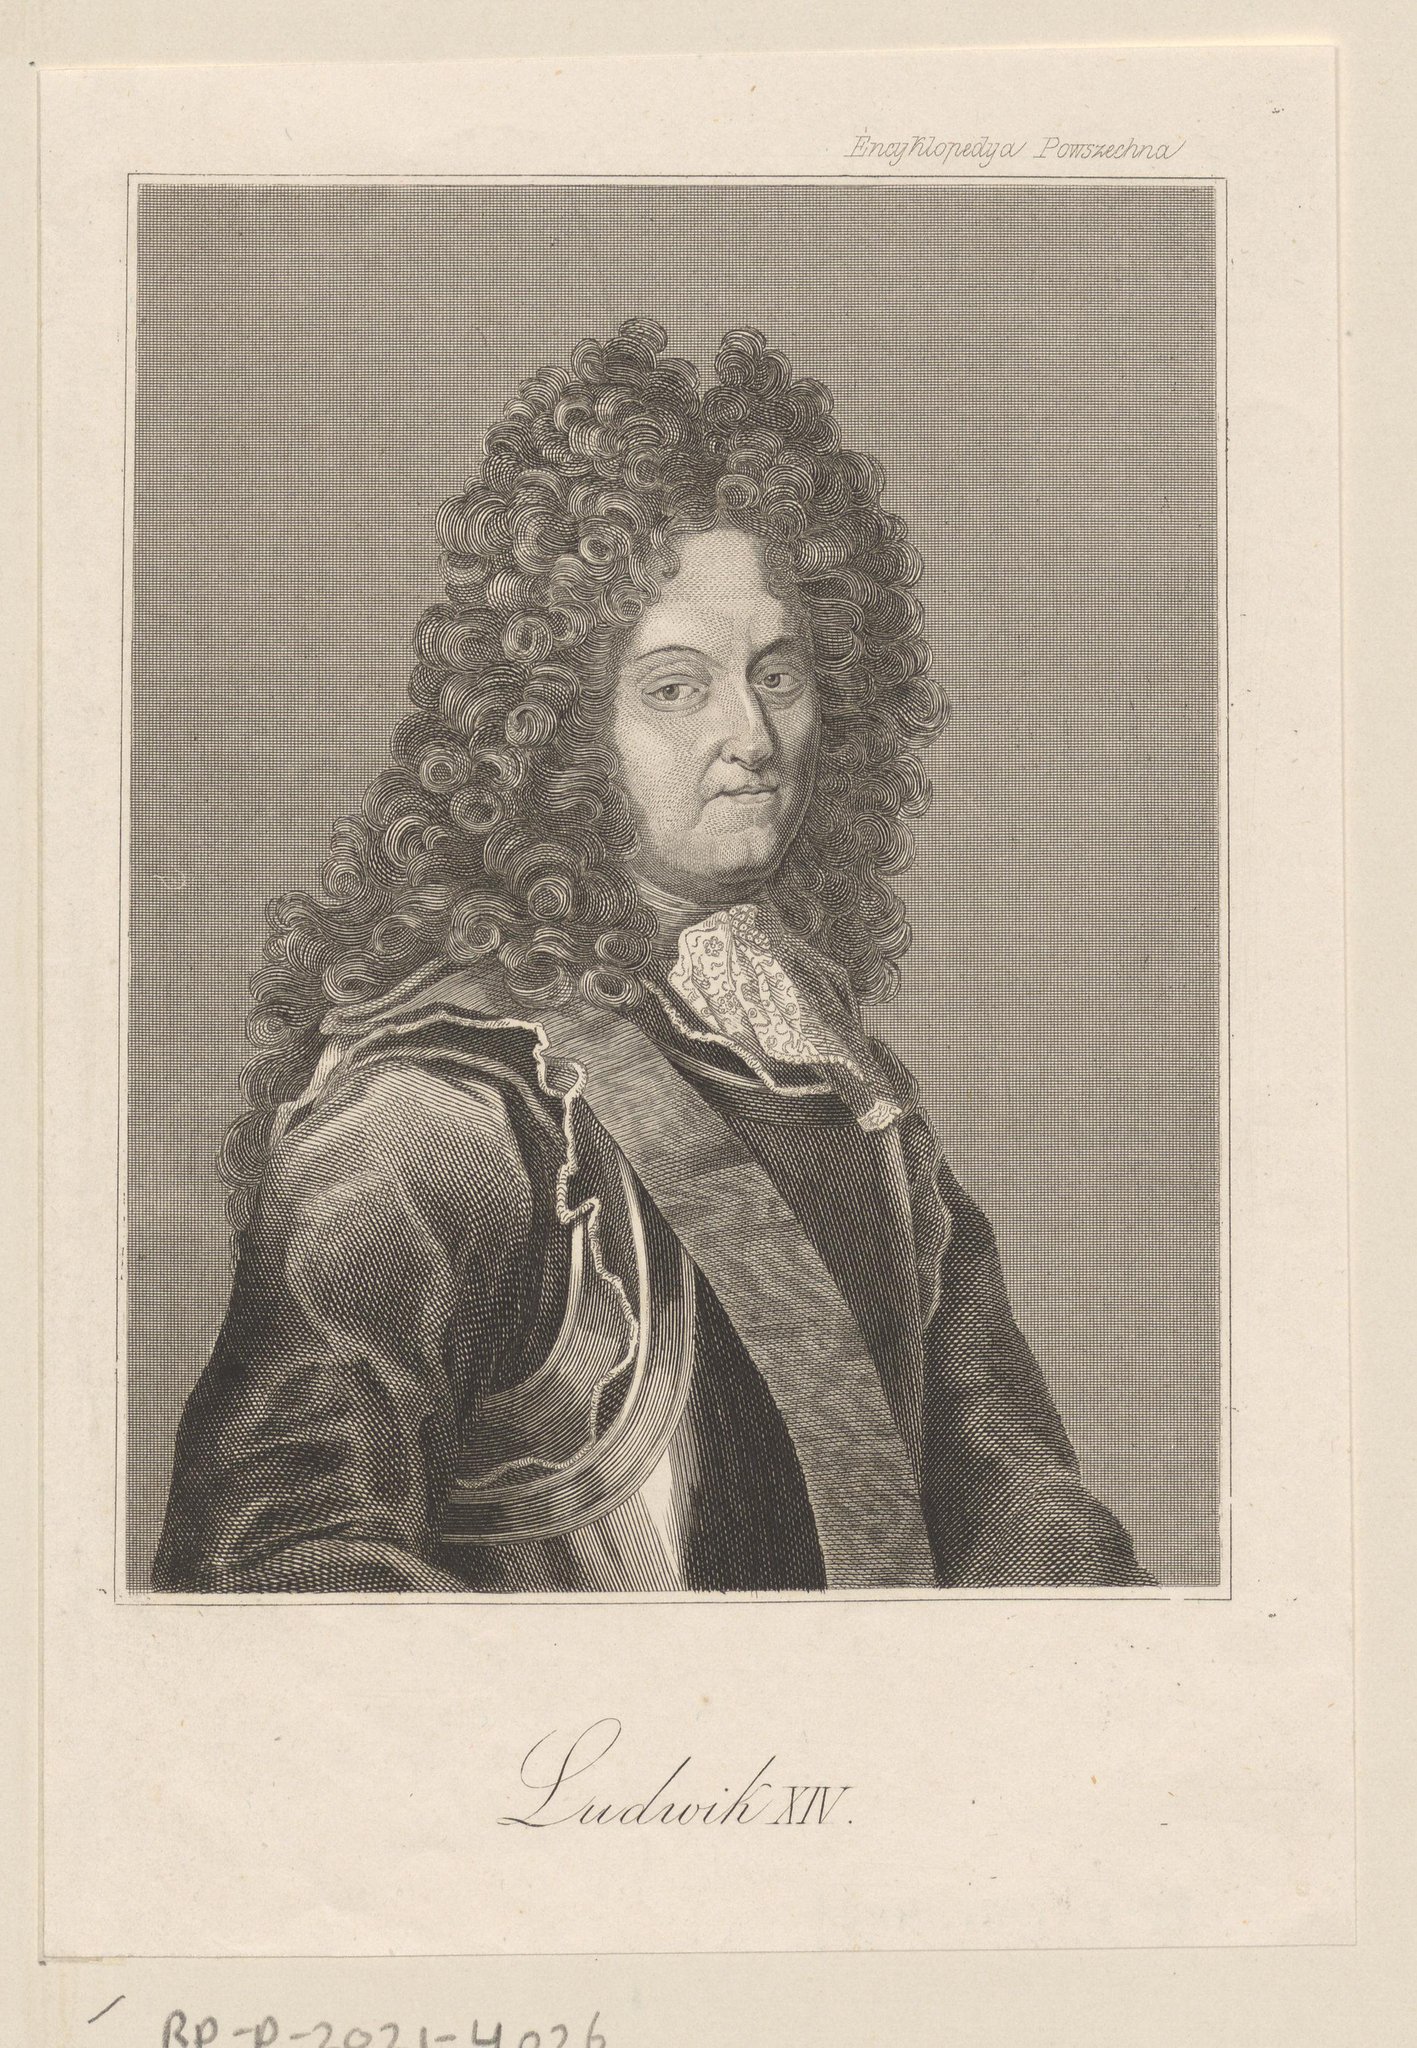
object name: print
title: Portret van Lodewijk XIV van Frankrijk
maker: Anonymous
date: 1836-1839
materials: paper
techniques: engraving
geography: poland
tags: lodewijk xiv (koning van frankrijk), armour, historical persons, king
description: Prent waarschijnlijk uit: Encyklopedya powszechna. Warschau: August Emmanuel Gücksberg, 1836-1839.